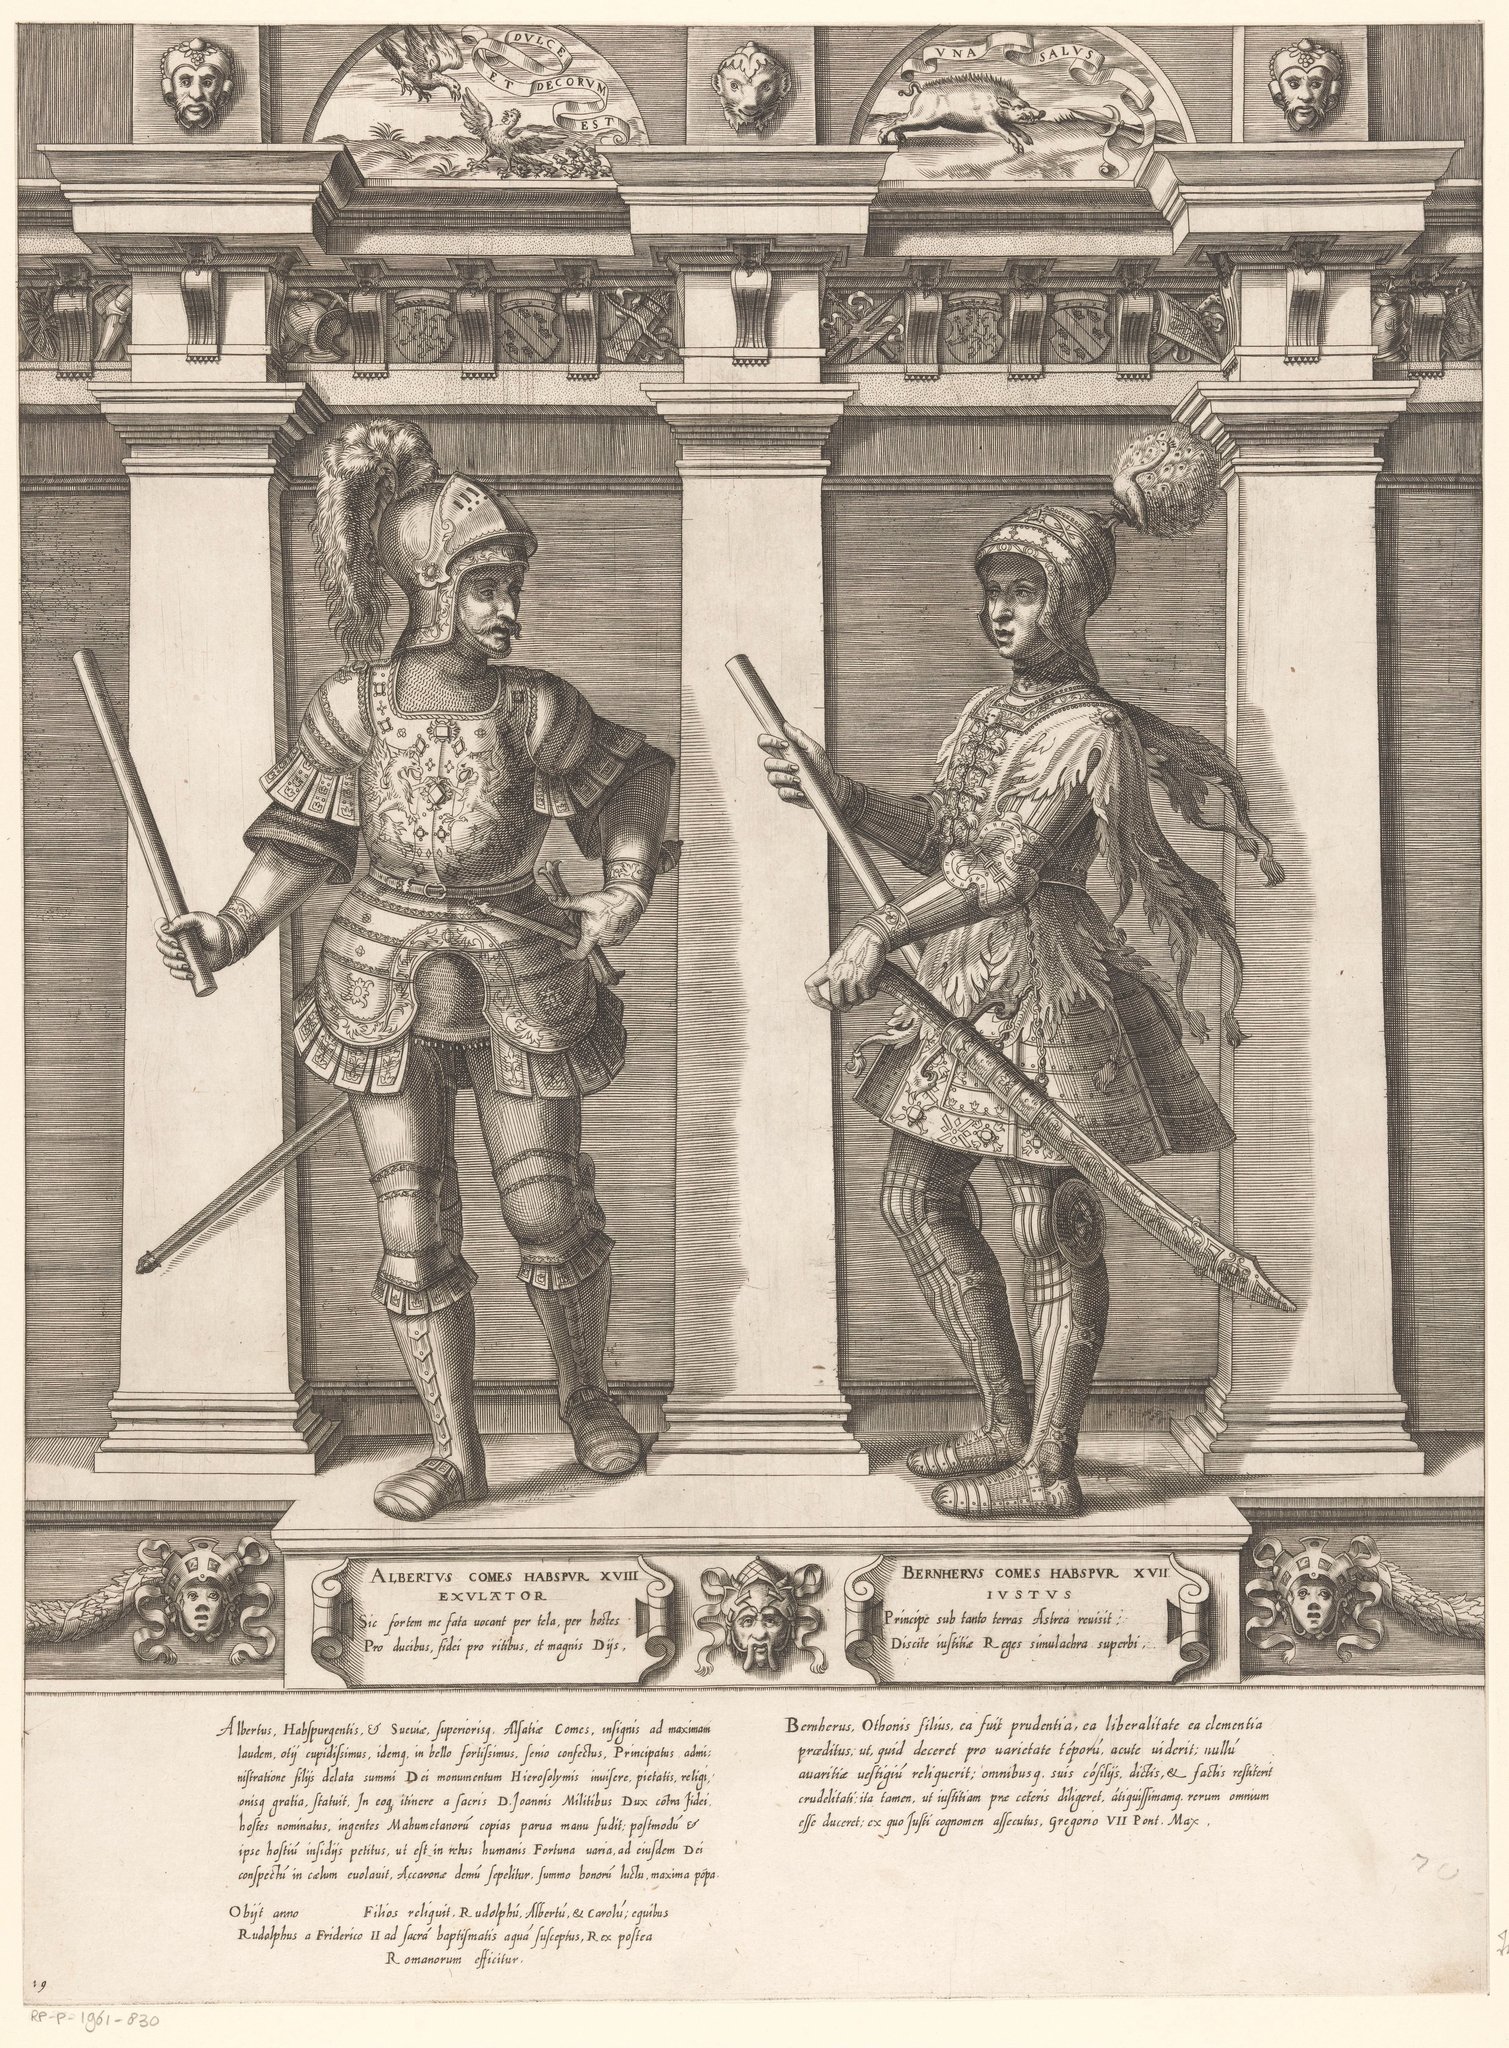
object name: print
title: Austriacae gentis imaginum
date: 1569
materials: paper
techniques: engraving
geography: italy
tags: earl, historical persons, ruler, sovereign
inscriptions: collector's mark: Lugt 2228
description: Deze prent maakt deel uit van een reeks van 58 prenten. Het meerendeel van de prenten bevat portretten van 74 leden van het Oostenrijkse Huis, naar tekeningen door Francesco Terzio, die deels getekend zijn naar de 28 levensgrote bronzen beelden die rond de cenotaaf van Maximiliaan I in de Hofkirche te Innsbruck staan.